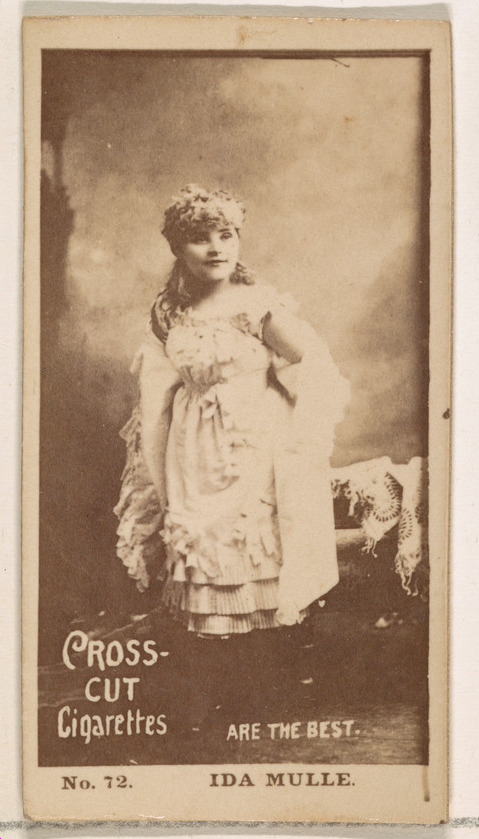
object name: print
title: Card Number 72, Ida Mulle, from the Actors and Actresses series (N145-2) issued by Duke Sons & Co. to promote Cross Cut Cigarettes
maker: w. duke, sons & co.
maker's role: publisher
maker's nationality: american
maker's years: 1870-1920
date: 1880-1889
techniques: albumen silver print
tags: portraits,women,actresses